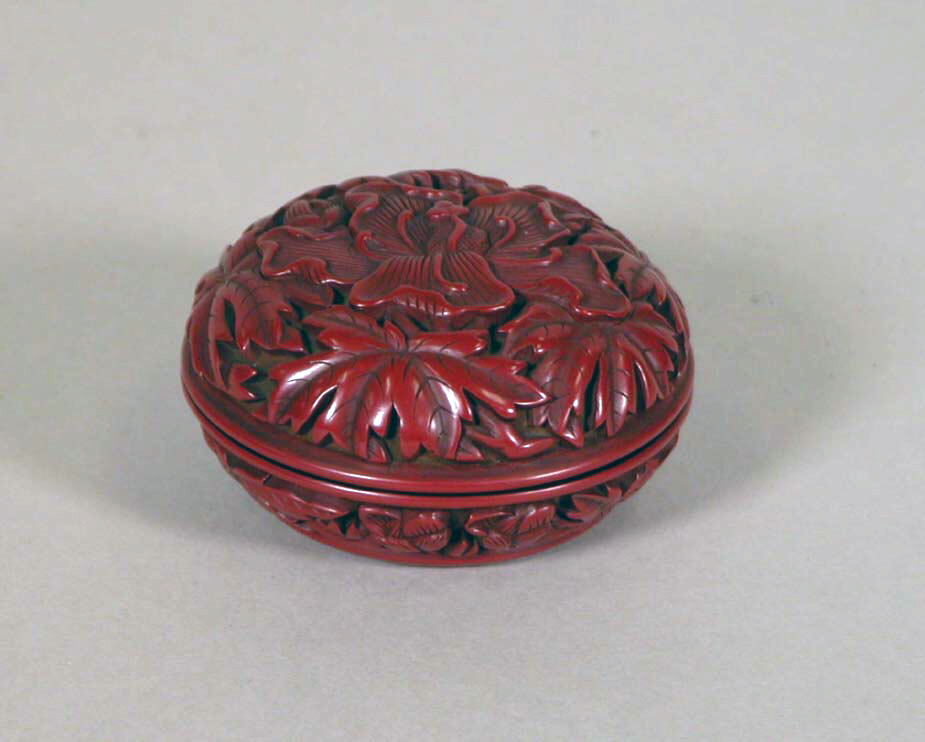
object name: covered incense box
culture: chinese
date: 1401-1500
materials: lacquer